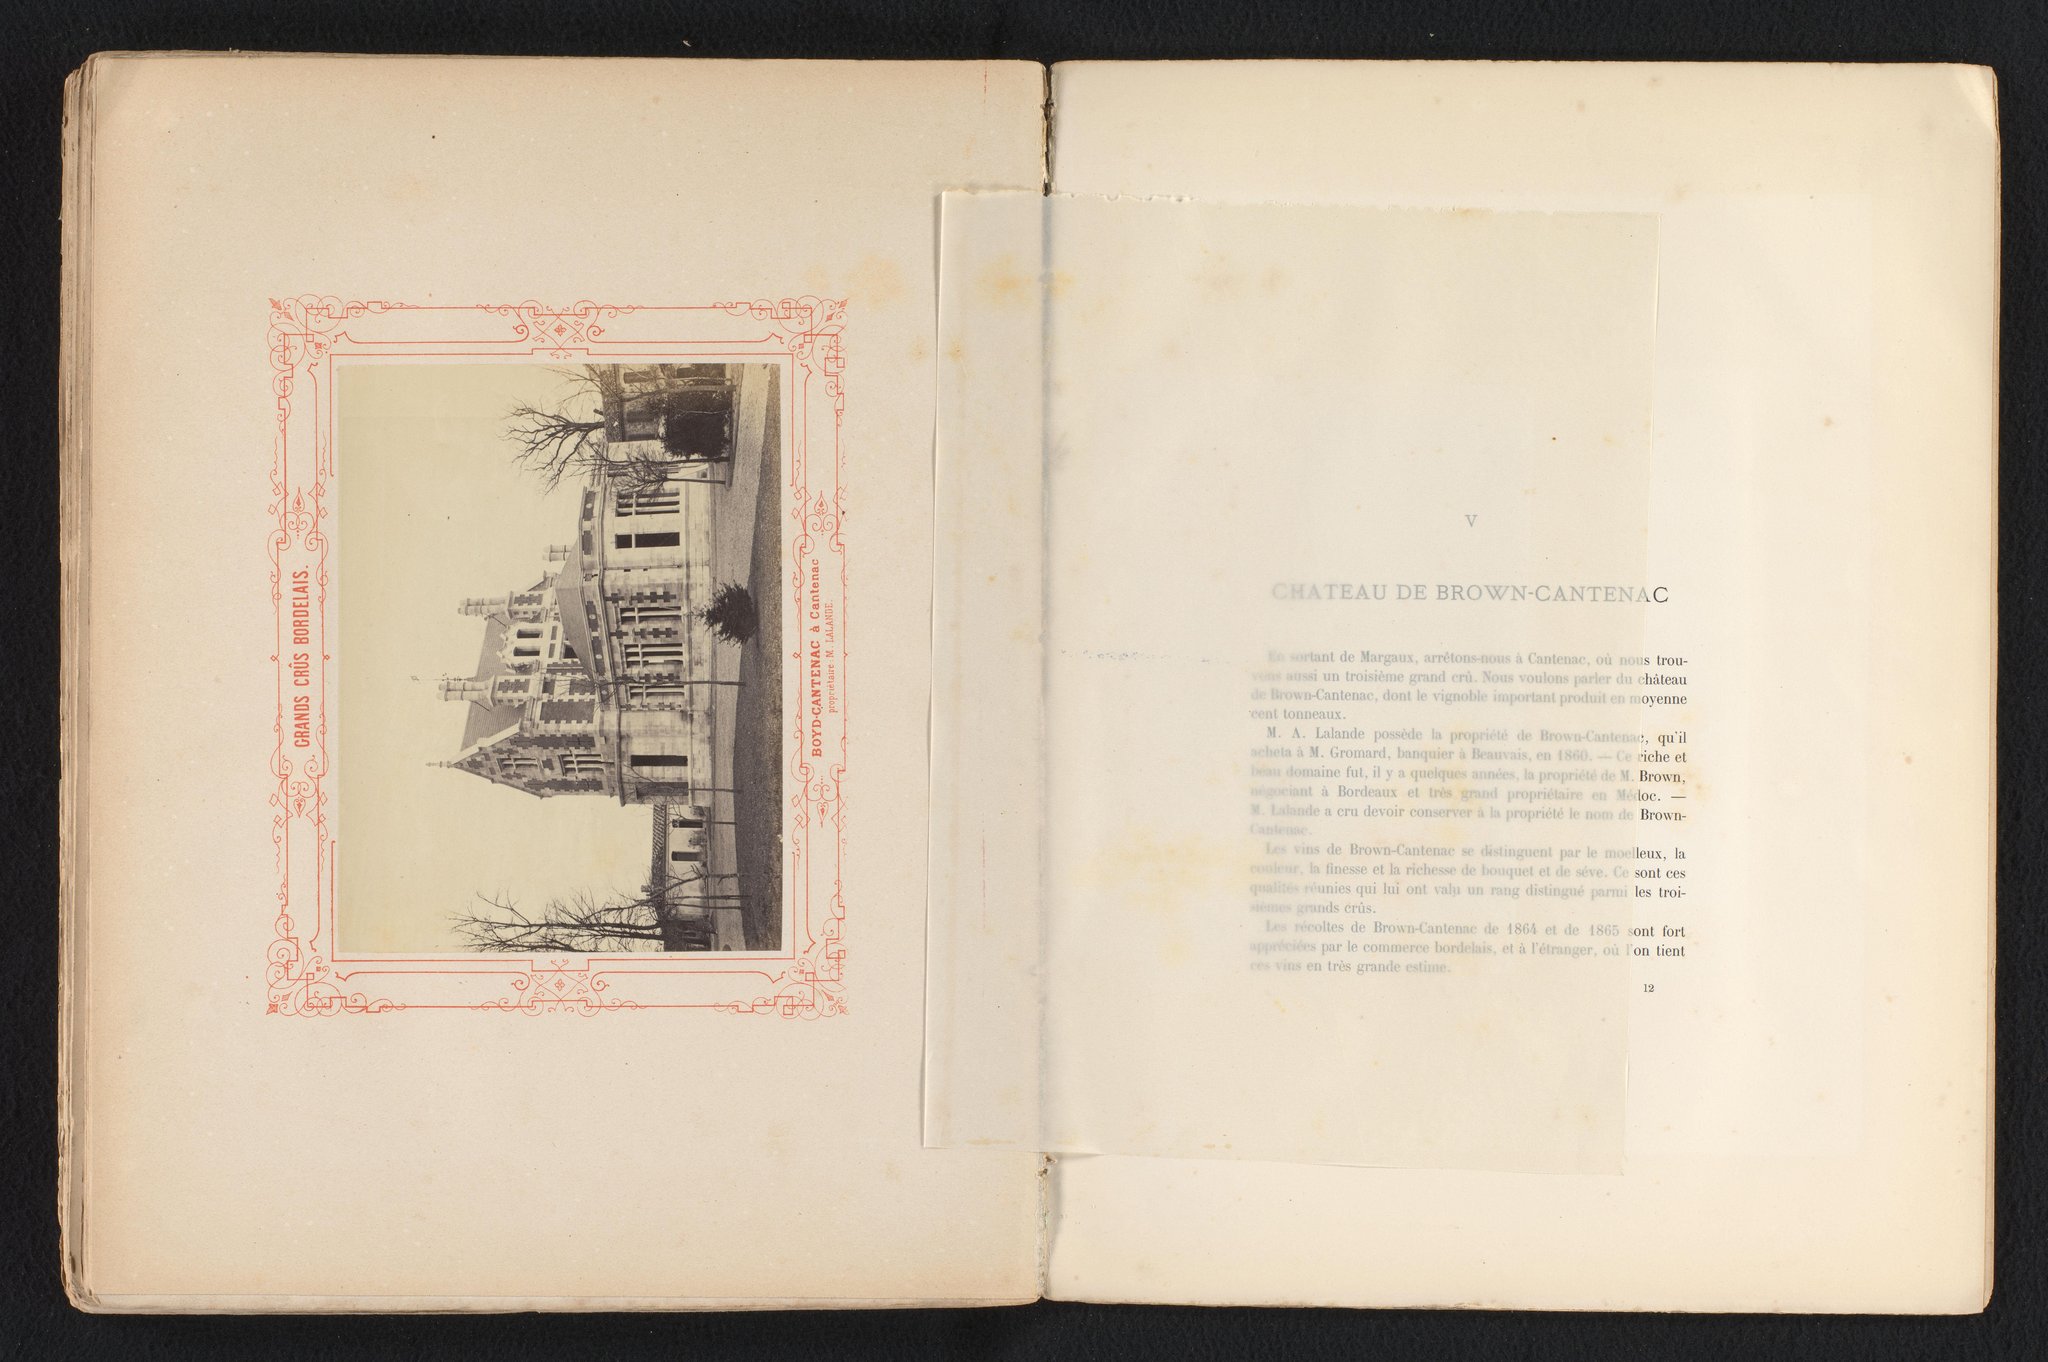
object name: page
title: Gezicht op Château Boyd-Cantenac in Cantenac, Frankrijk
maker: alfred danflou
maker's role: fotograaf, schrijver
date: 1862-1867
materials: paper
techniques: albumen print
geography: cantenac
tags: castle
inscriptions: inscription: ‘propriétaire: M. LALANDE.’